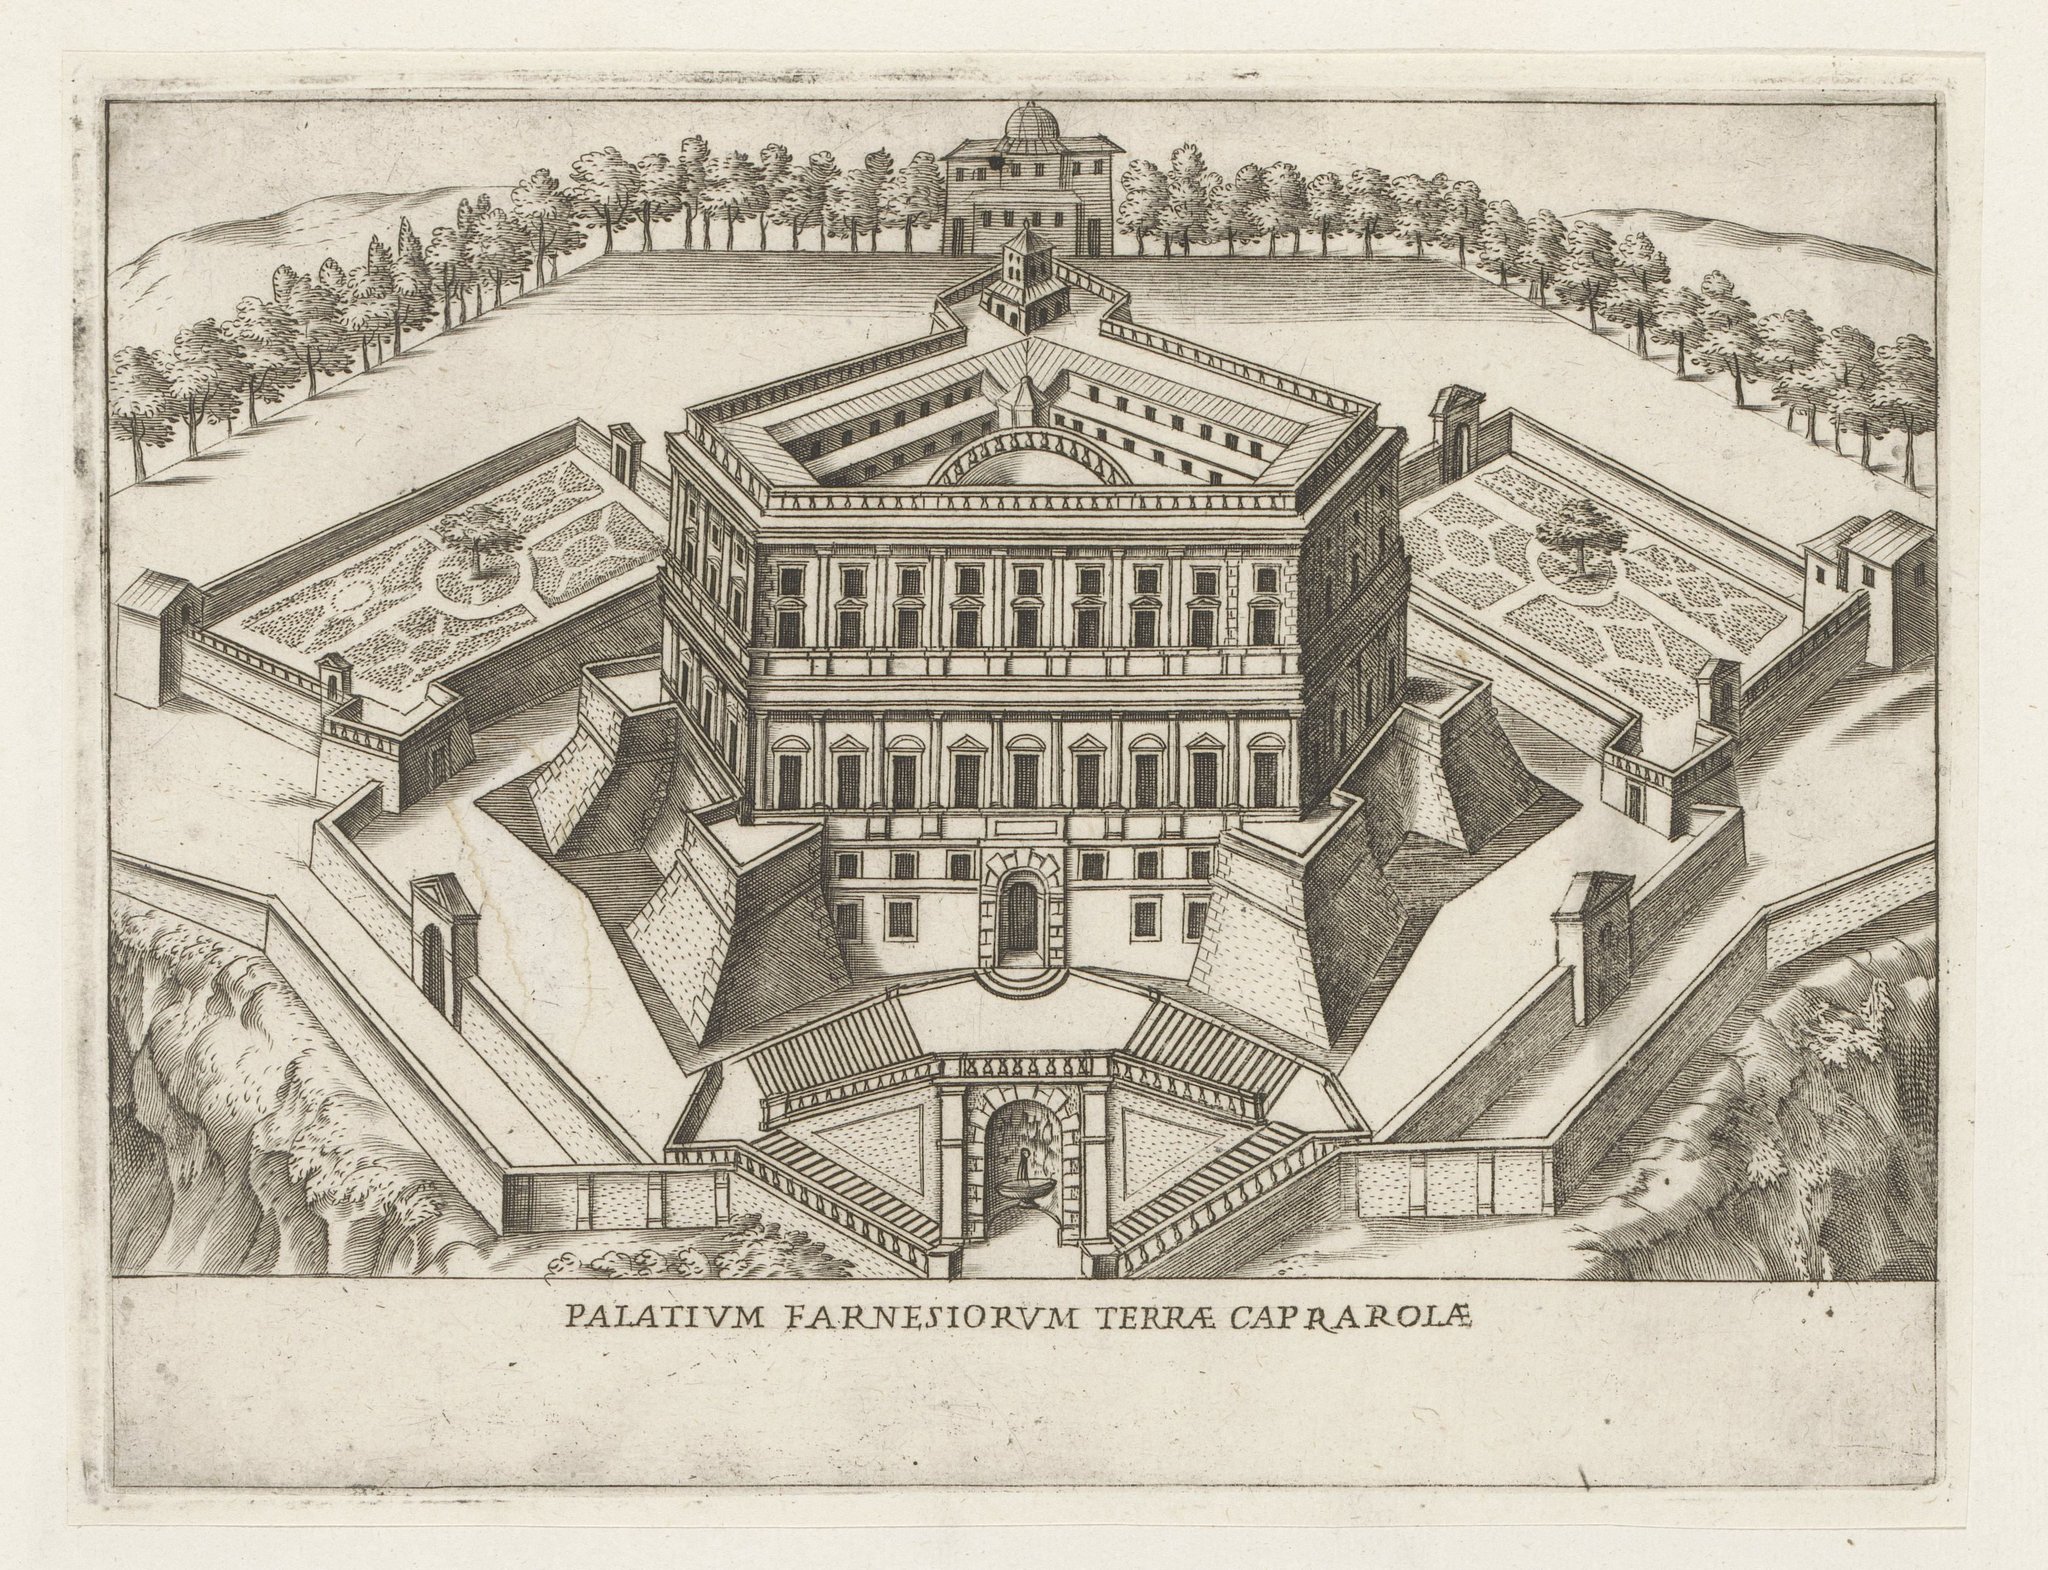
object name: album leaf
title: Magesyn der Italiaense gebouwen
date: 1638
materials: paper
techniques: etching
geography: italy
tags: villa